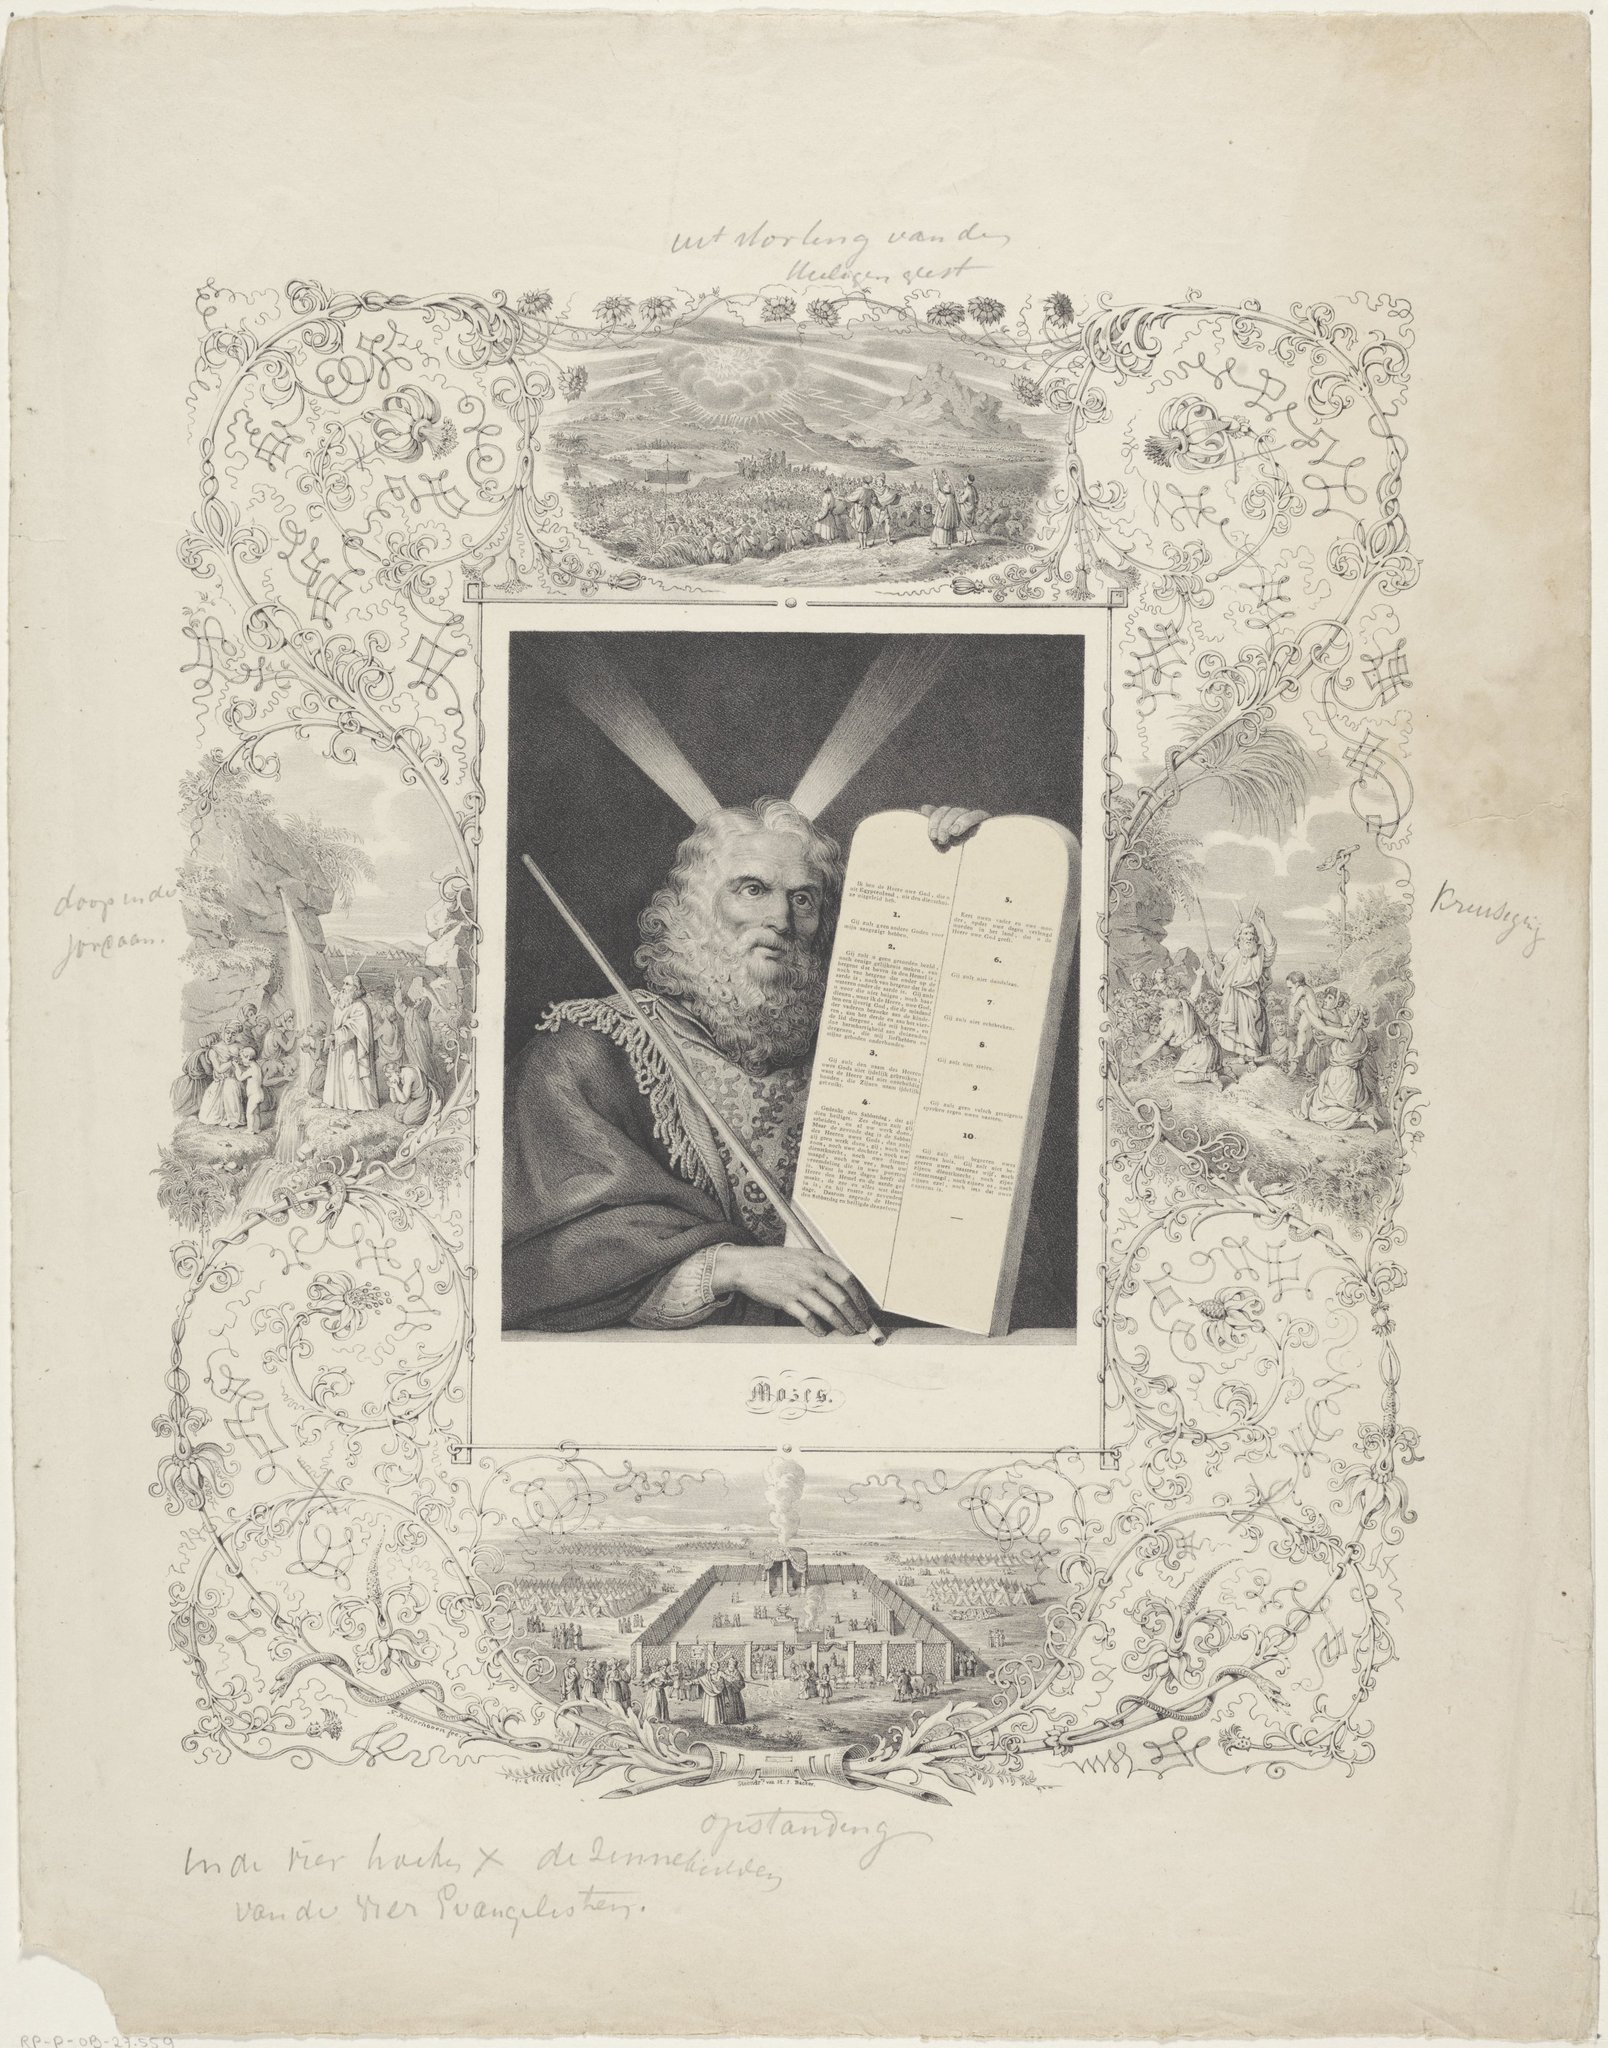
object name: print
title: Mozes met de tien geboden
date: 1822-1845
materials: paper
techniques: lithograph, snipping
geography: dordrecht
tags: moses teaching (in general), the court of the tabernacle ~ jewish religion, moses receives the tables of the law from god, anyone who is bitten by a snake is cured by looking at the brazen serpent; the serpent (or dragon) is usually depicted on a tau-shaped cross or on a pillar, moses striking water from the rock (exodus 17:1-7; numbers 20:2-13), mount sinai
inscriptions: inscription: ‘doop in de jordaan’, inscription: ‘opstanding’, collector's mark: Lugt 2228, inscription: ‘uitstorting van de heilige geest’, inscription: ‘X’, inscription: ‘In de vier hoeken X de zinnebeelden va nde vier Evangelisten’, inscription: ‘kruisiging’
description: Mozes heeft een stenen tafel in zijn hand met daarop de tien geboden. In zijn rechterhand een aanwijsstok. Om het portret een decoratief patroon van bloemen en planten. Daarin vier taferelen. Bovenin ontvangt het volk van Israël de Mozaïsche wetten. Rechts Mozes en de koperen slang. Midden onder de tabernakel en links slaat Mozes water uit een rots.